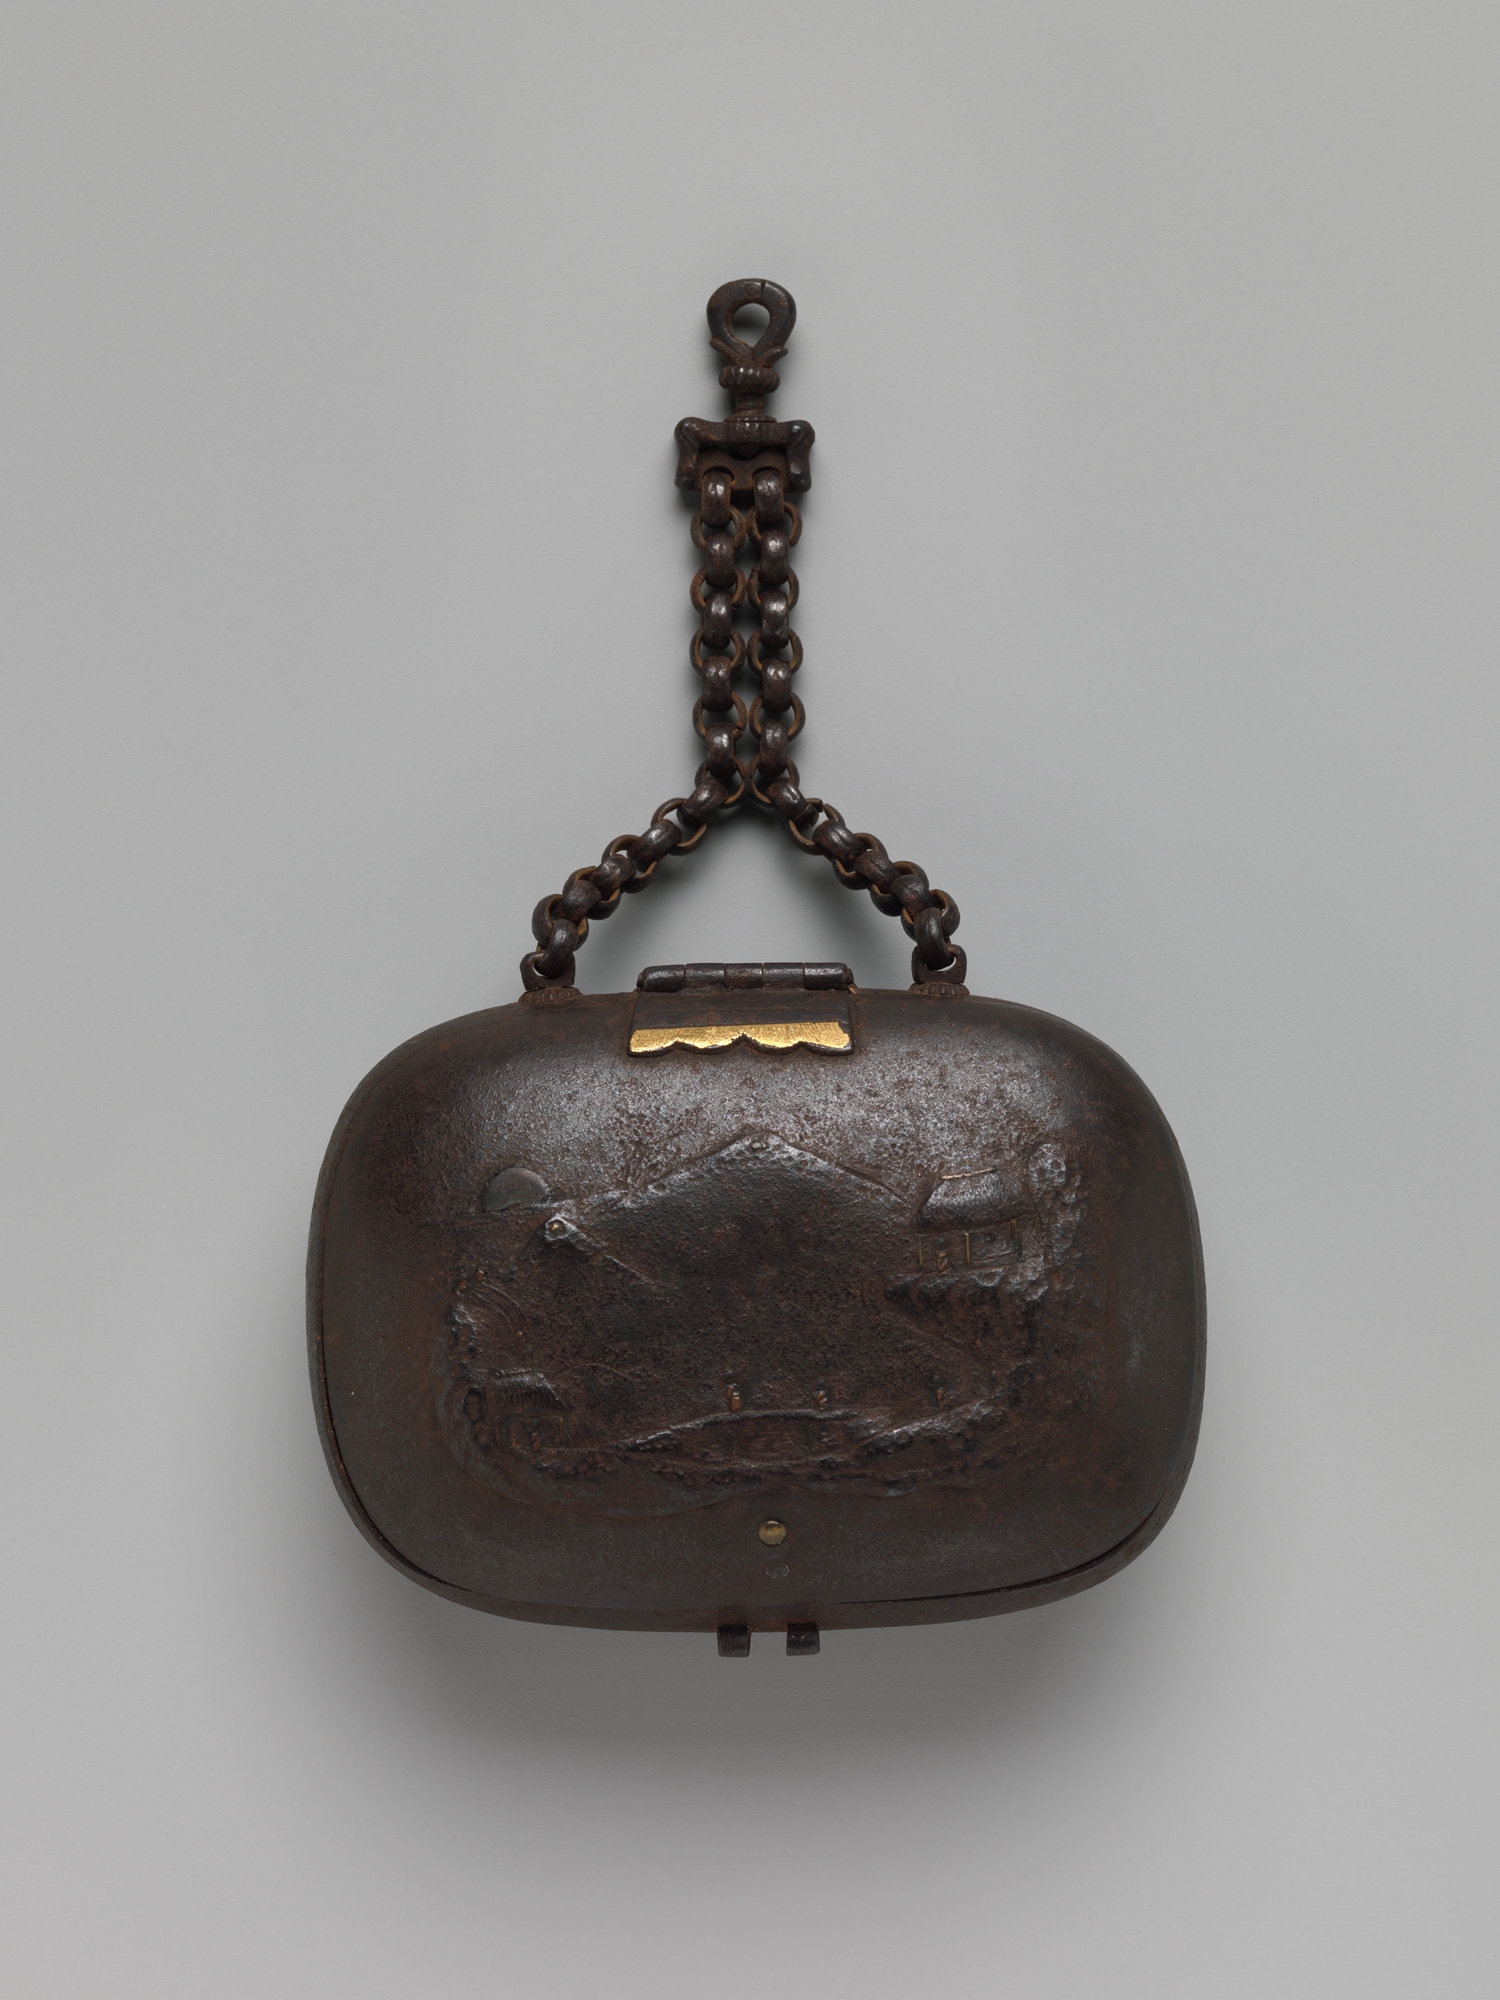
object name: tobacco pouch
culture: japanese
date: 1701-1800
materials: iron